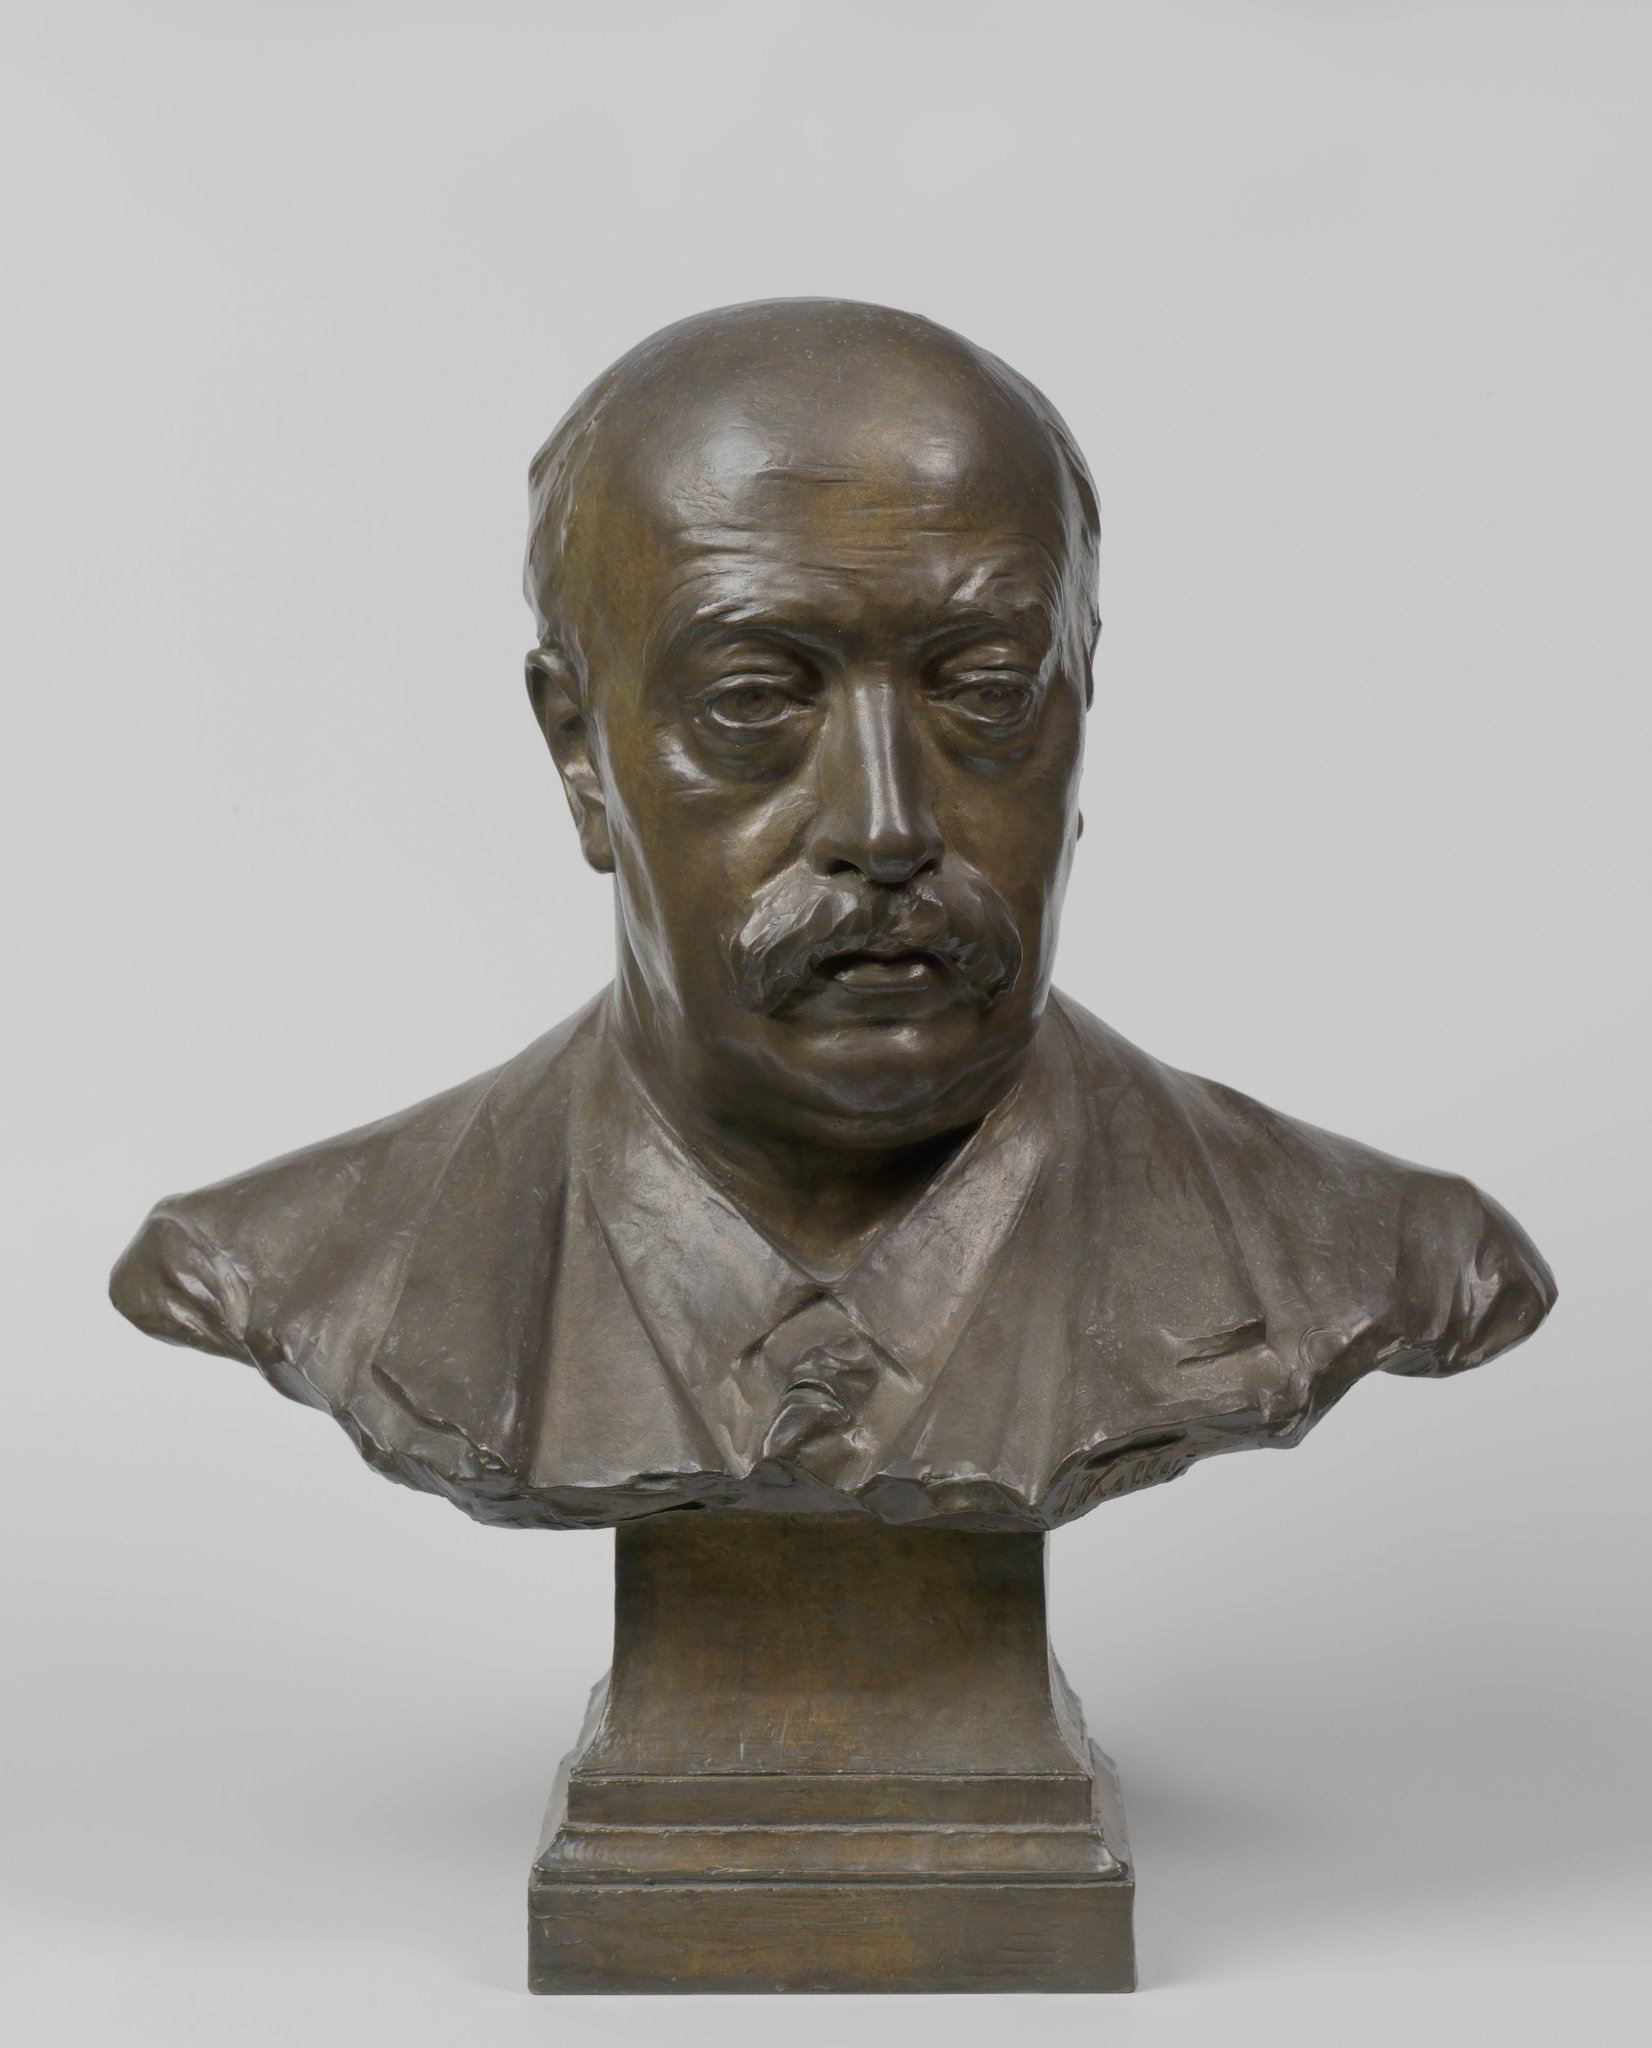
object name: sculpture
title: Borstbeeld van Gerard Keller (1829-1899), letterkundige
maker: johan keller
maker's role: sculptor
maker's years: 1863-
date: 1840-1900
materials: bronze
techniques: casting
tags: gouda, arnhem, gerard keller